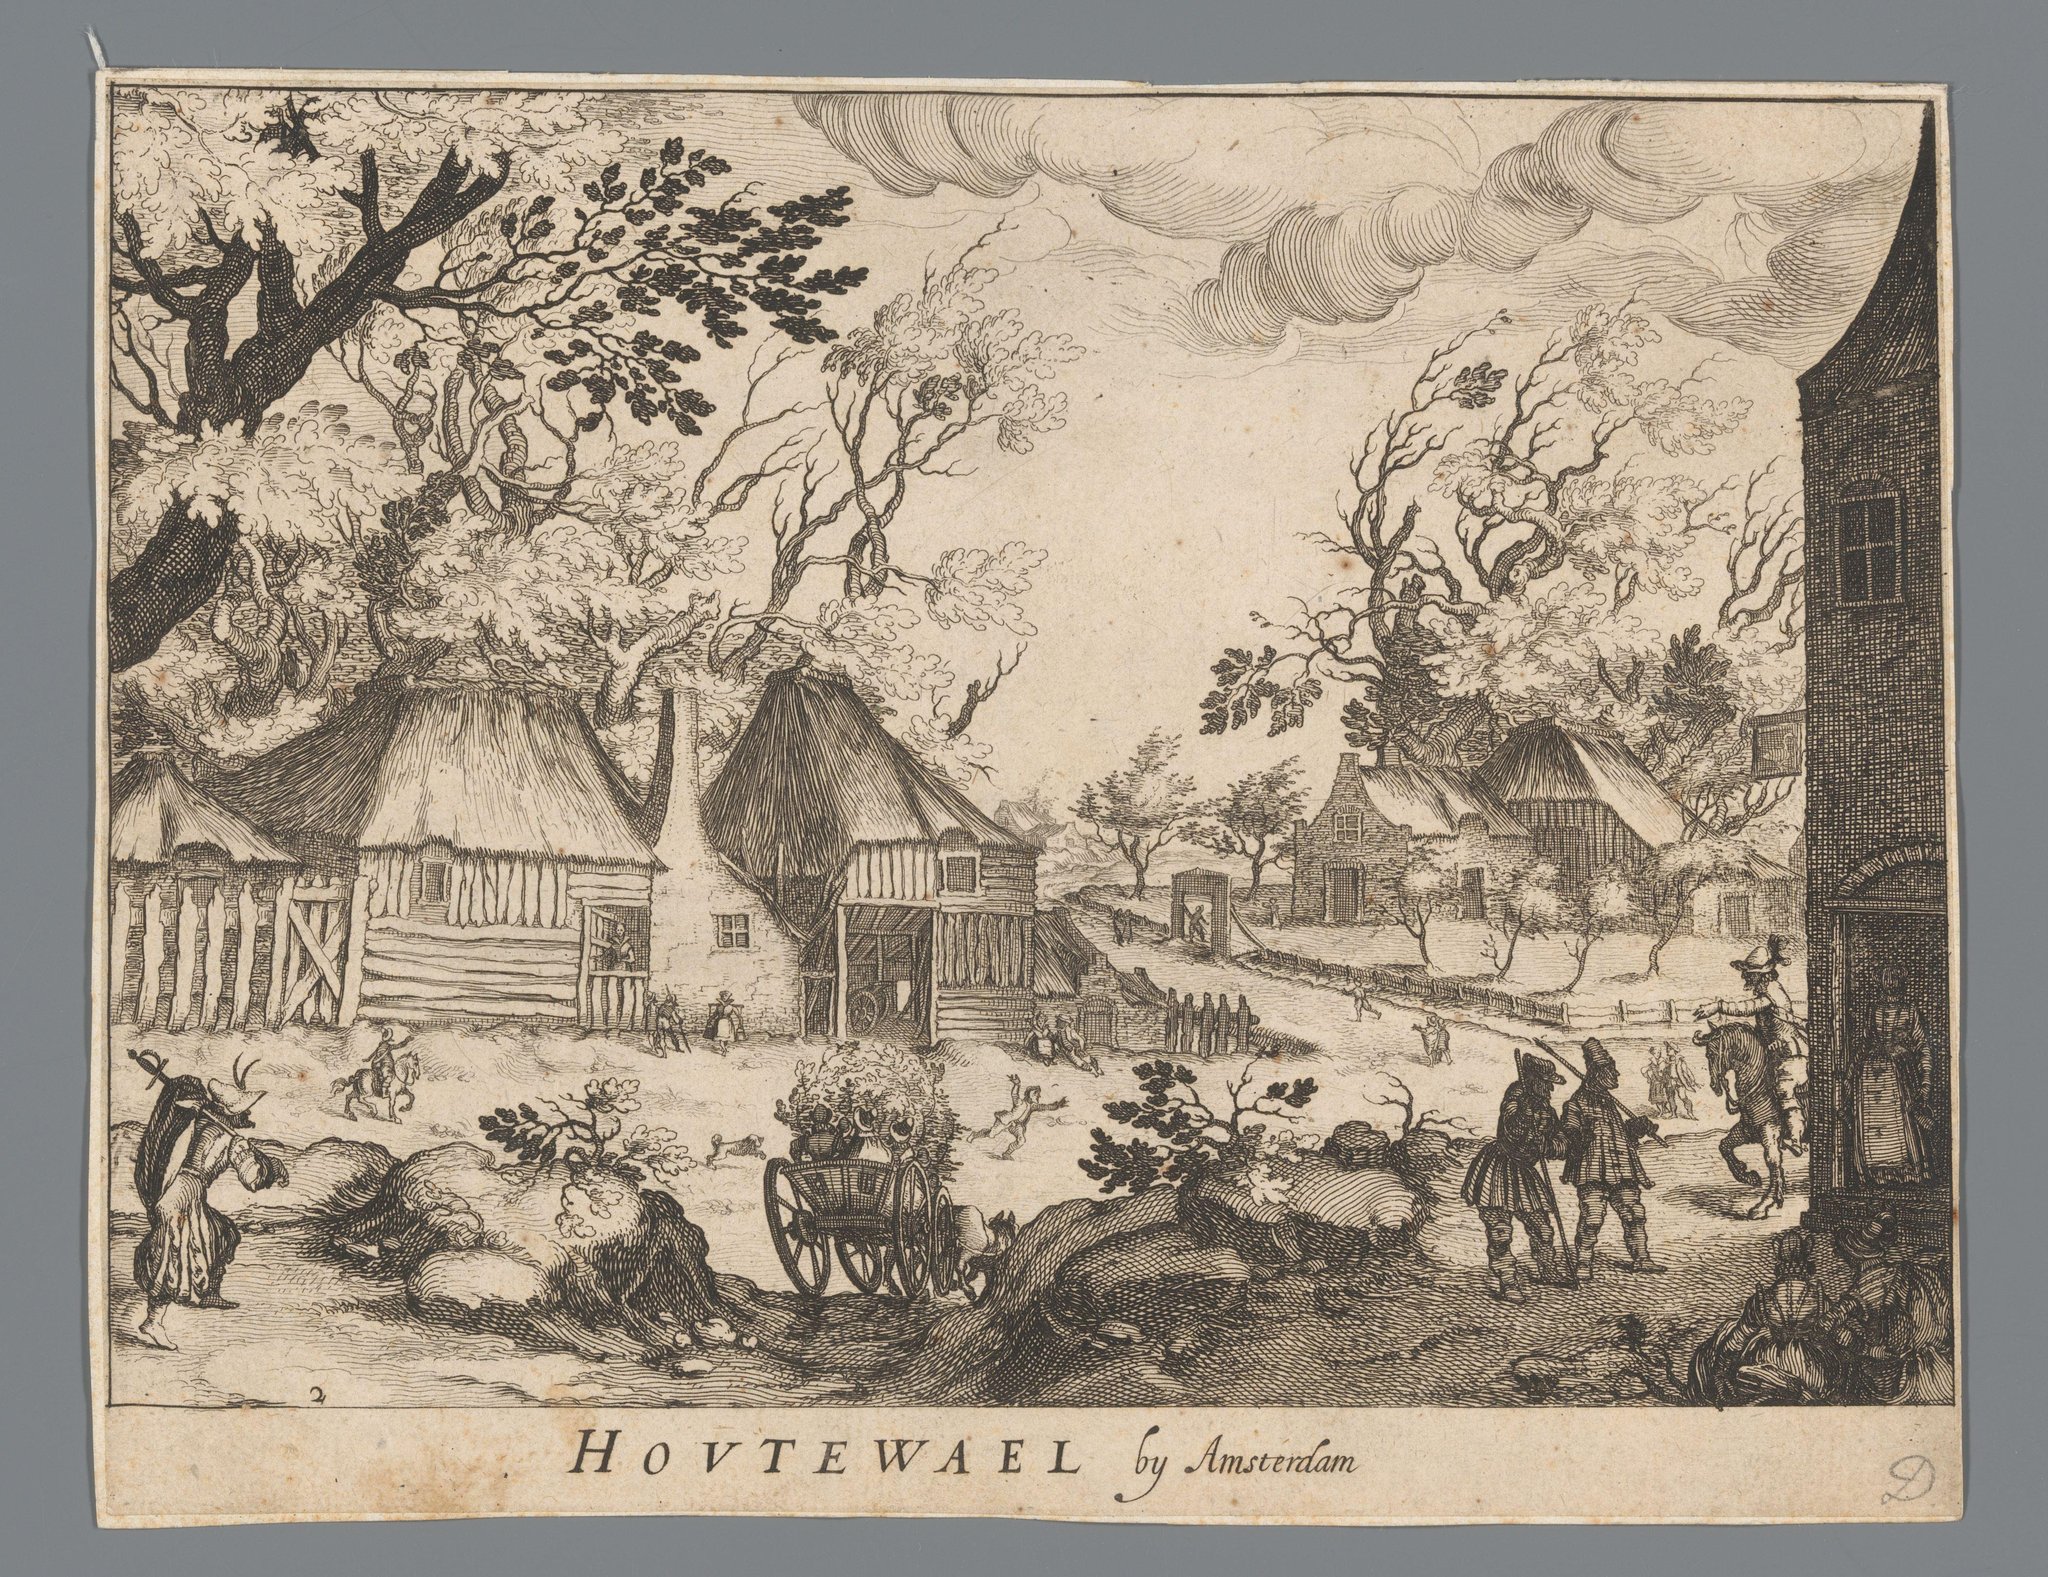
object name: print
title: Gezicht op Houtewael nabij Amsterdam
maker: simon frisius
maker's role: print maker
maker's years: 1570-1628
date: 1600-1610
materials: paper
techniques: engraving, etching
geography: northern netherlands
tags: prospect of village, silhouette of village (+ city(-scape) with figures, staffage)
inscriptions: collector's mark: Lugt 2228